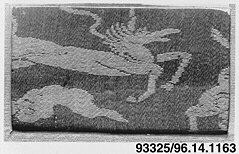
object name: piece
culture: japanese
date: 1701-1900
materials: silk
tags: horses